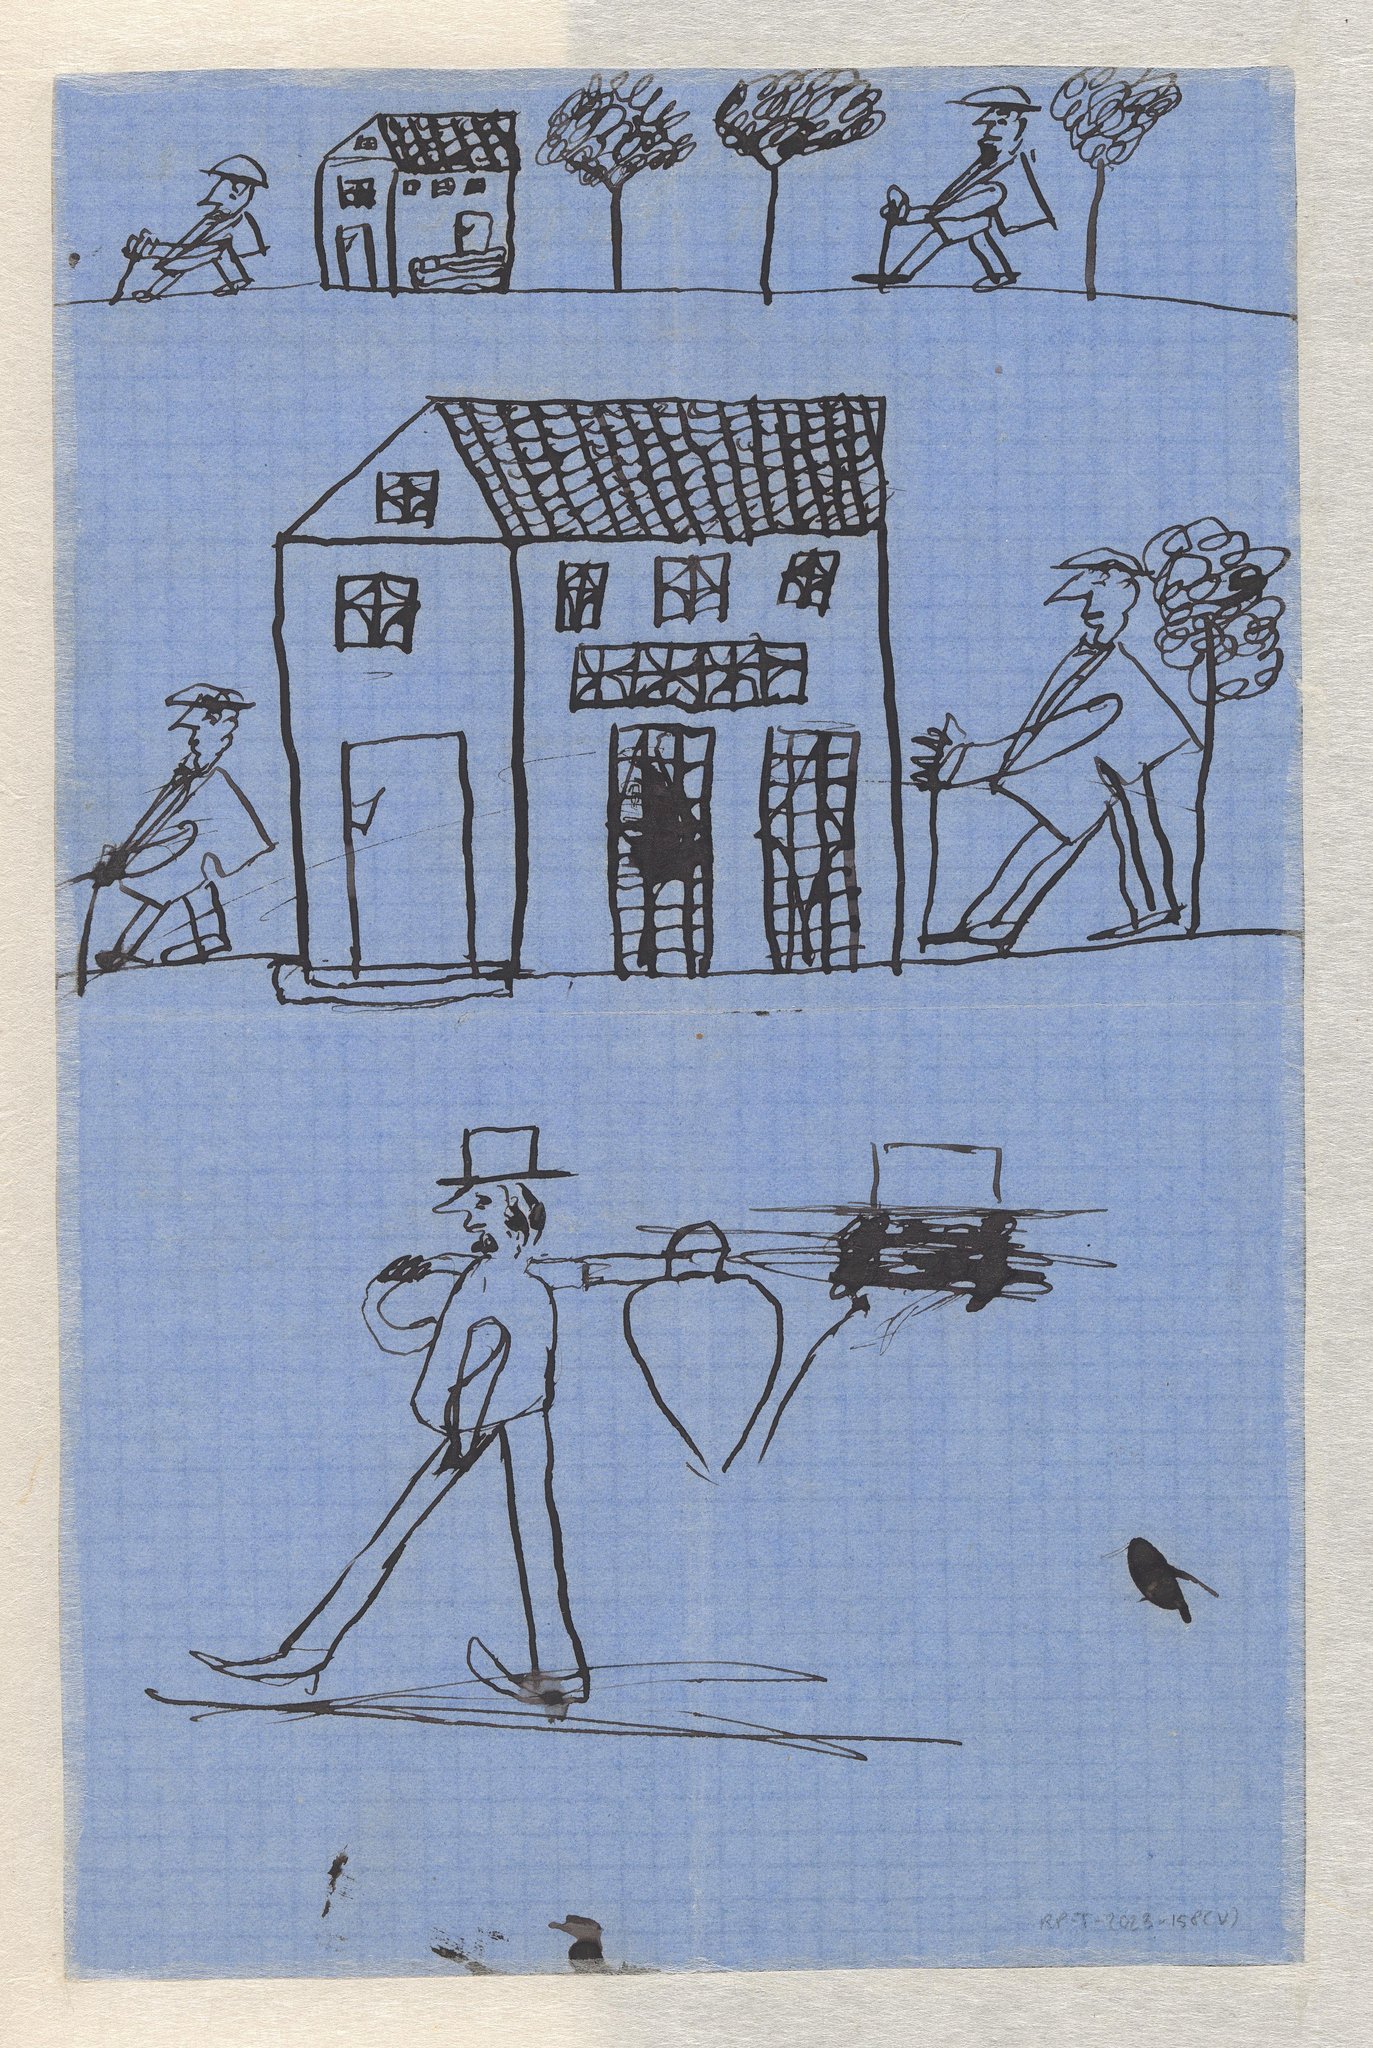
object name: drawing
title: Kindertekening van lopende figuren en een huis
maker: joannes carolus alberdingk thijm (jan)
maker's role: pater, schrijver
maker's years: 1847-1926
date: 1855-1865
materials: ink, paper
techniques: pen, writing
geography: netherlands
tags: urban housing, walking